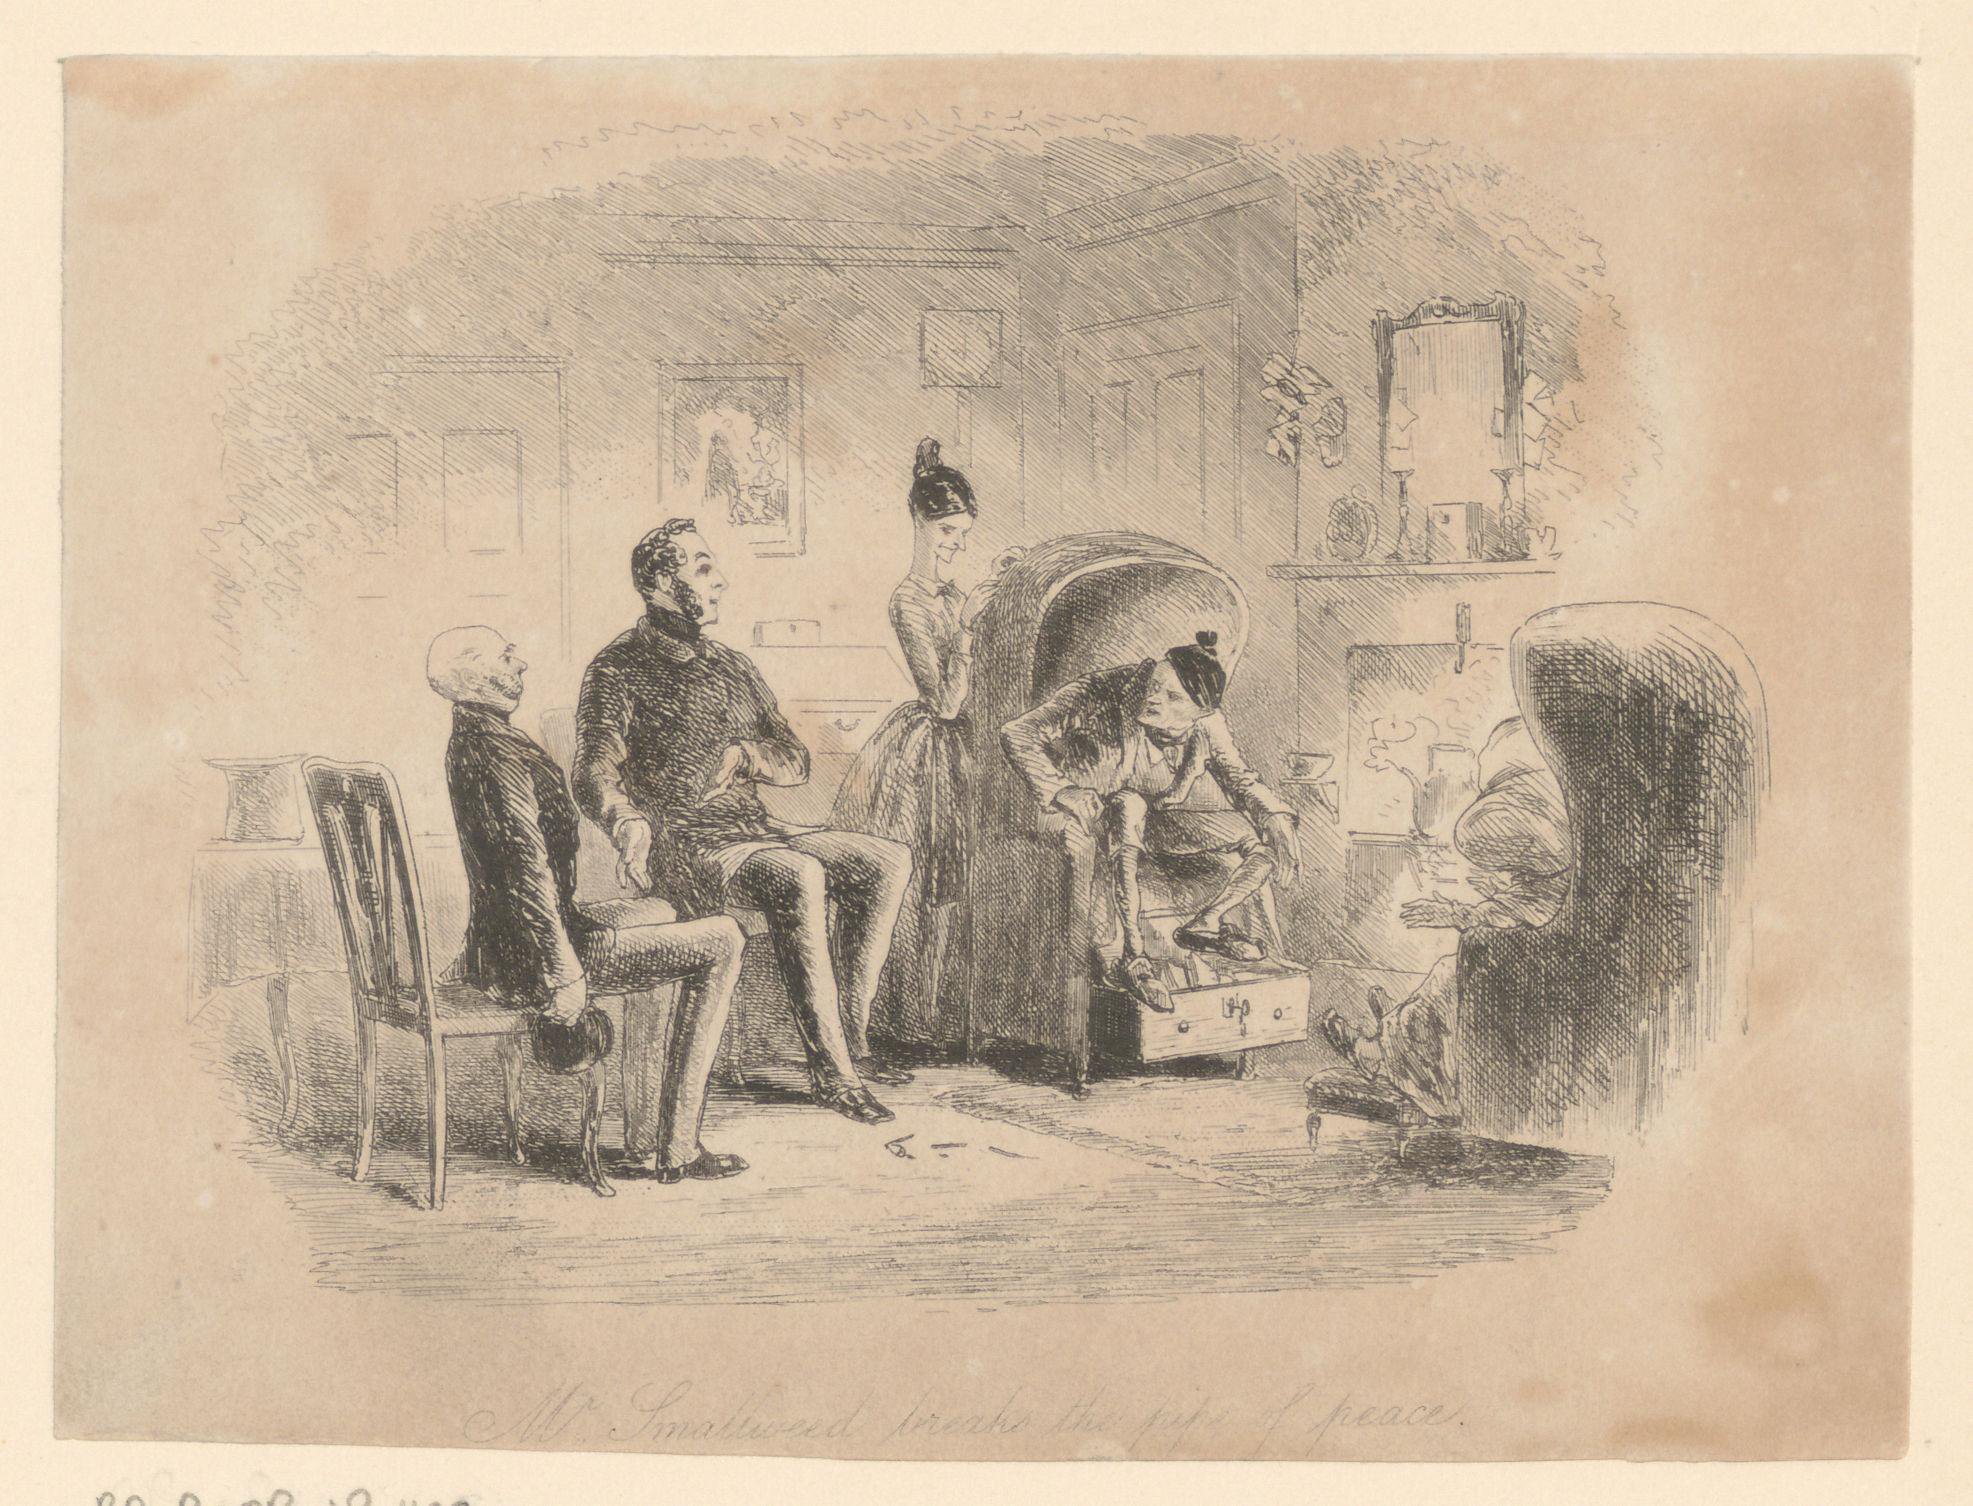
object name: book illustration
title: Grootvader Smallweed gooit zijn pijp op de grond en draait zich richting Matthew Bagnet en George Rouncewell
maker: hablot knight browne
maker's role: print maker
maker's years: 1815-1882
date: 1853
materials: paper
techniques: etching, roulette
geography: london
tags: pipe ~ tobacco, living-room, parlour, sitting-room, rage, anger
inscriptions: collector's mark: Lugt 2228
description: Prent uit: Dickens, Charles. Bleak House. Londen: Bradbury & Evans, 1853, p. 338.